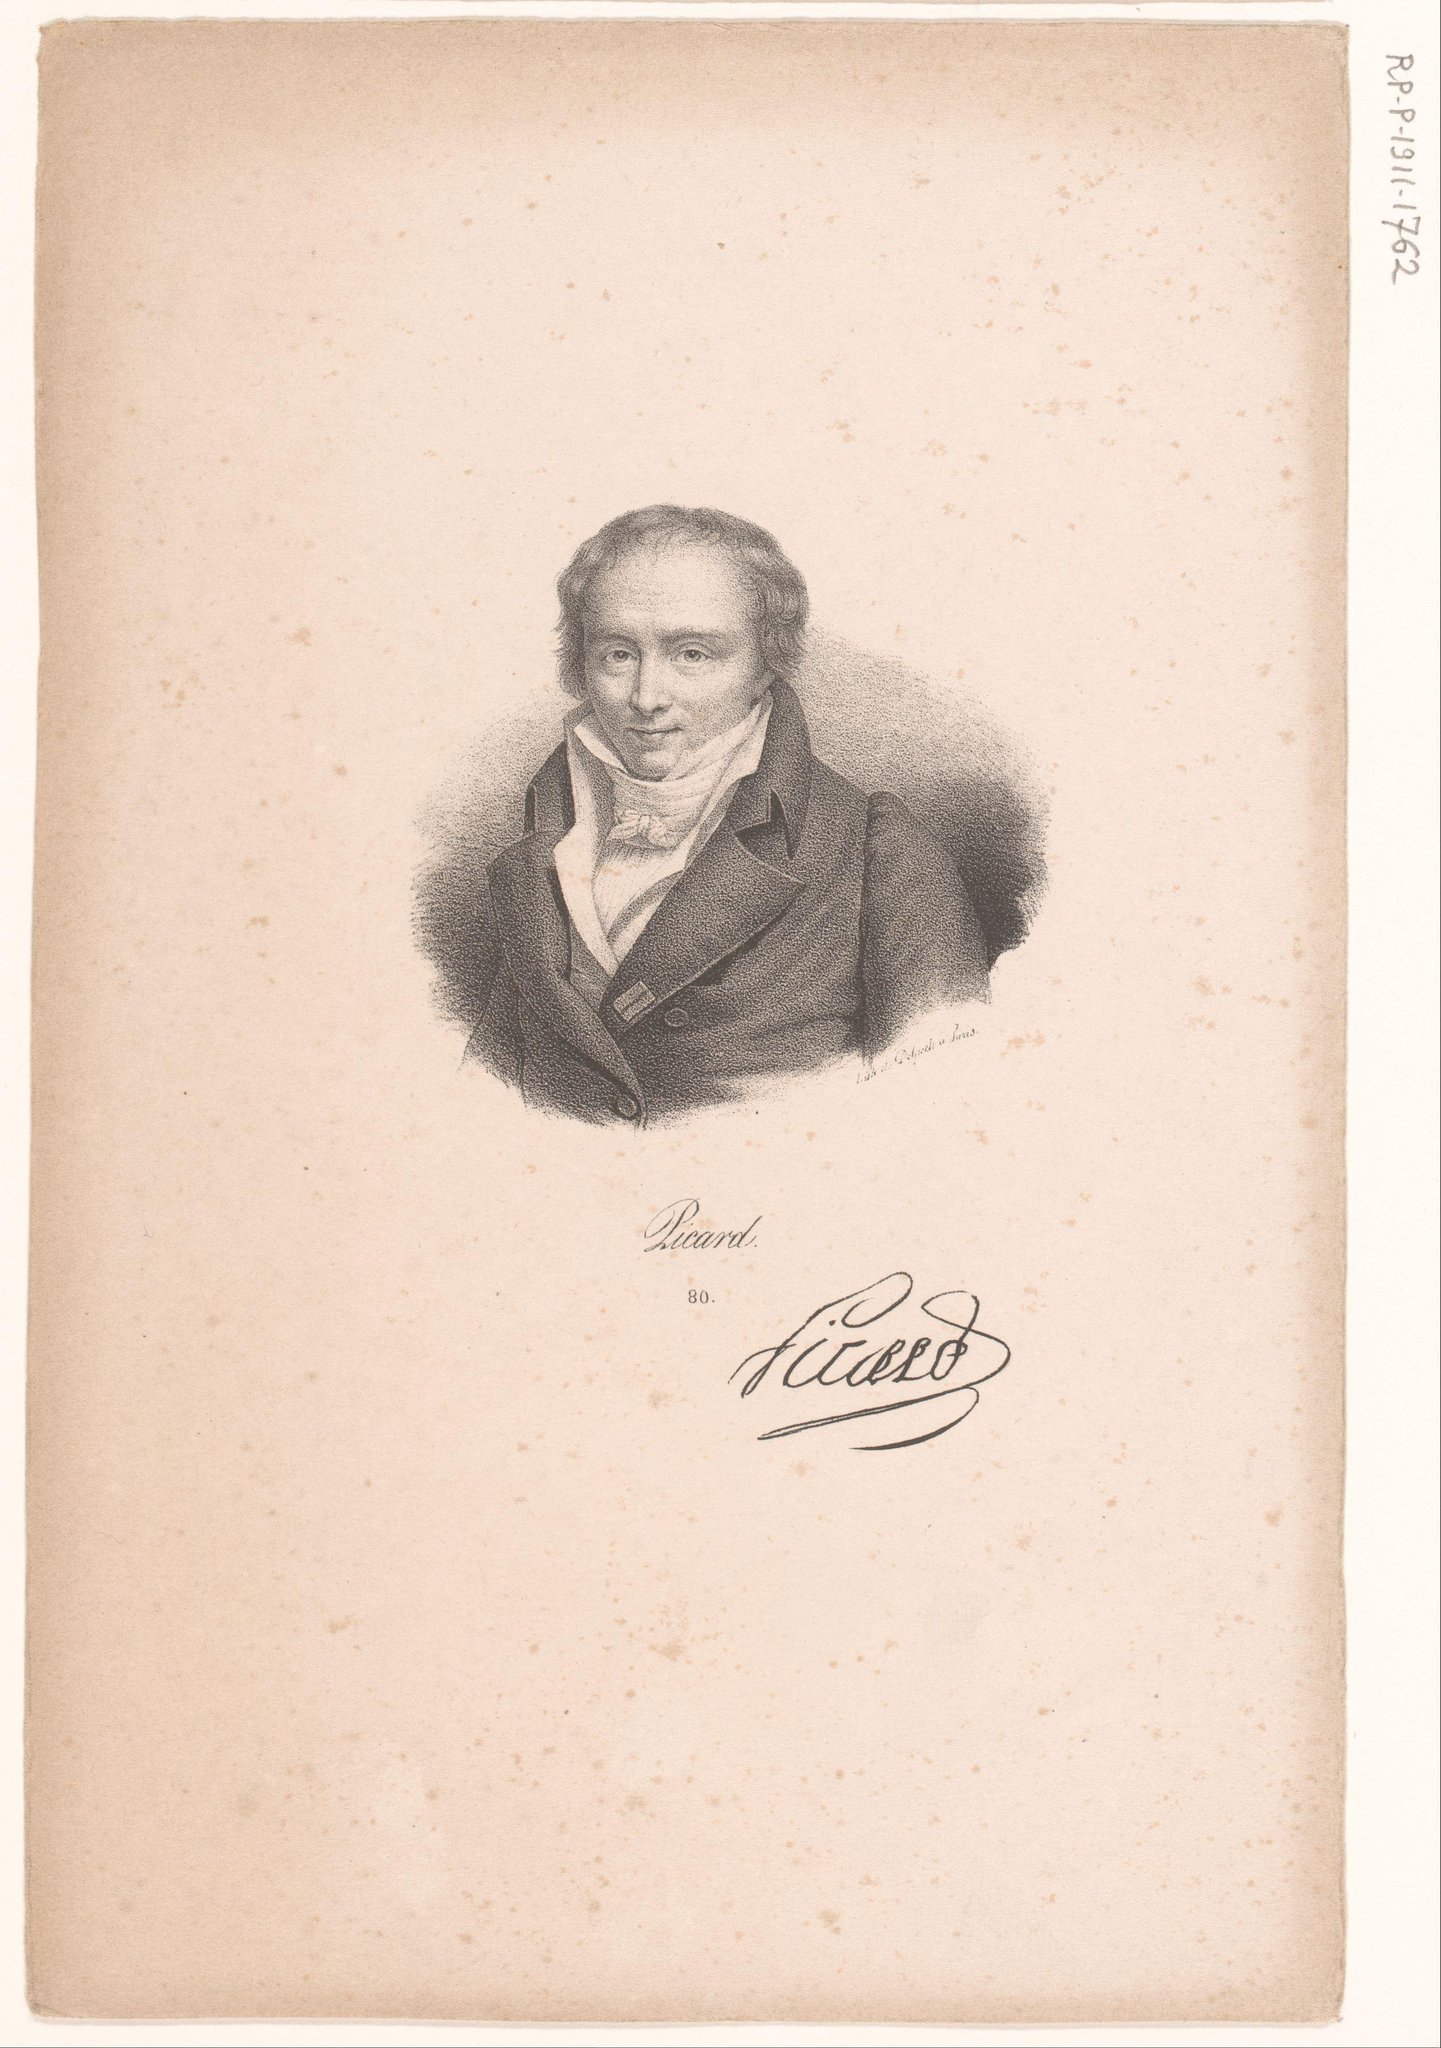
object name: print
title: Picard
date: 1818-1842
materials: paper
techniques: lithograph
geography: paris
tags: historical persons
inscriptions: collector's mark: Lugt 2228a